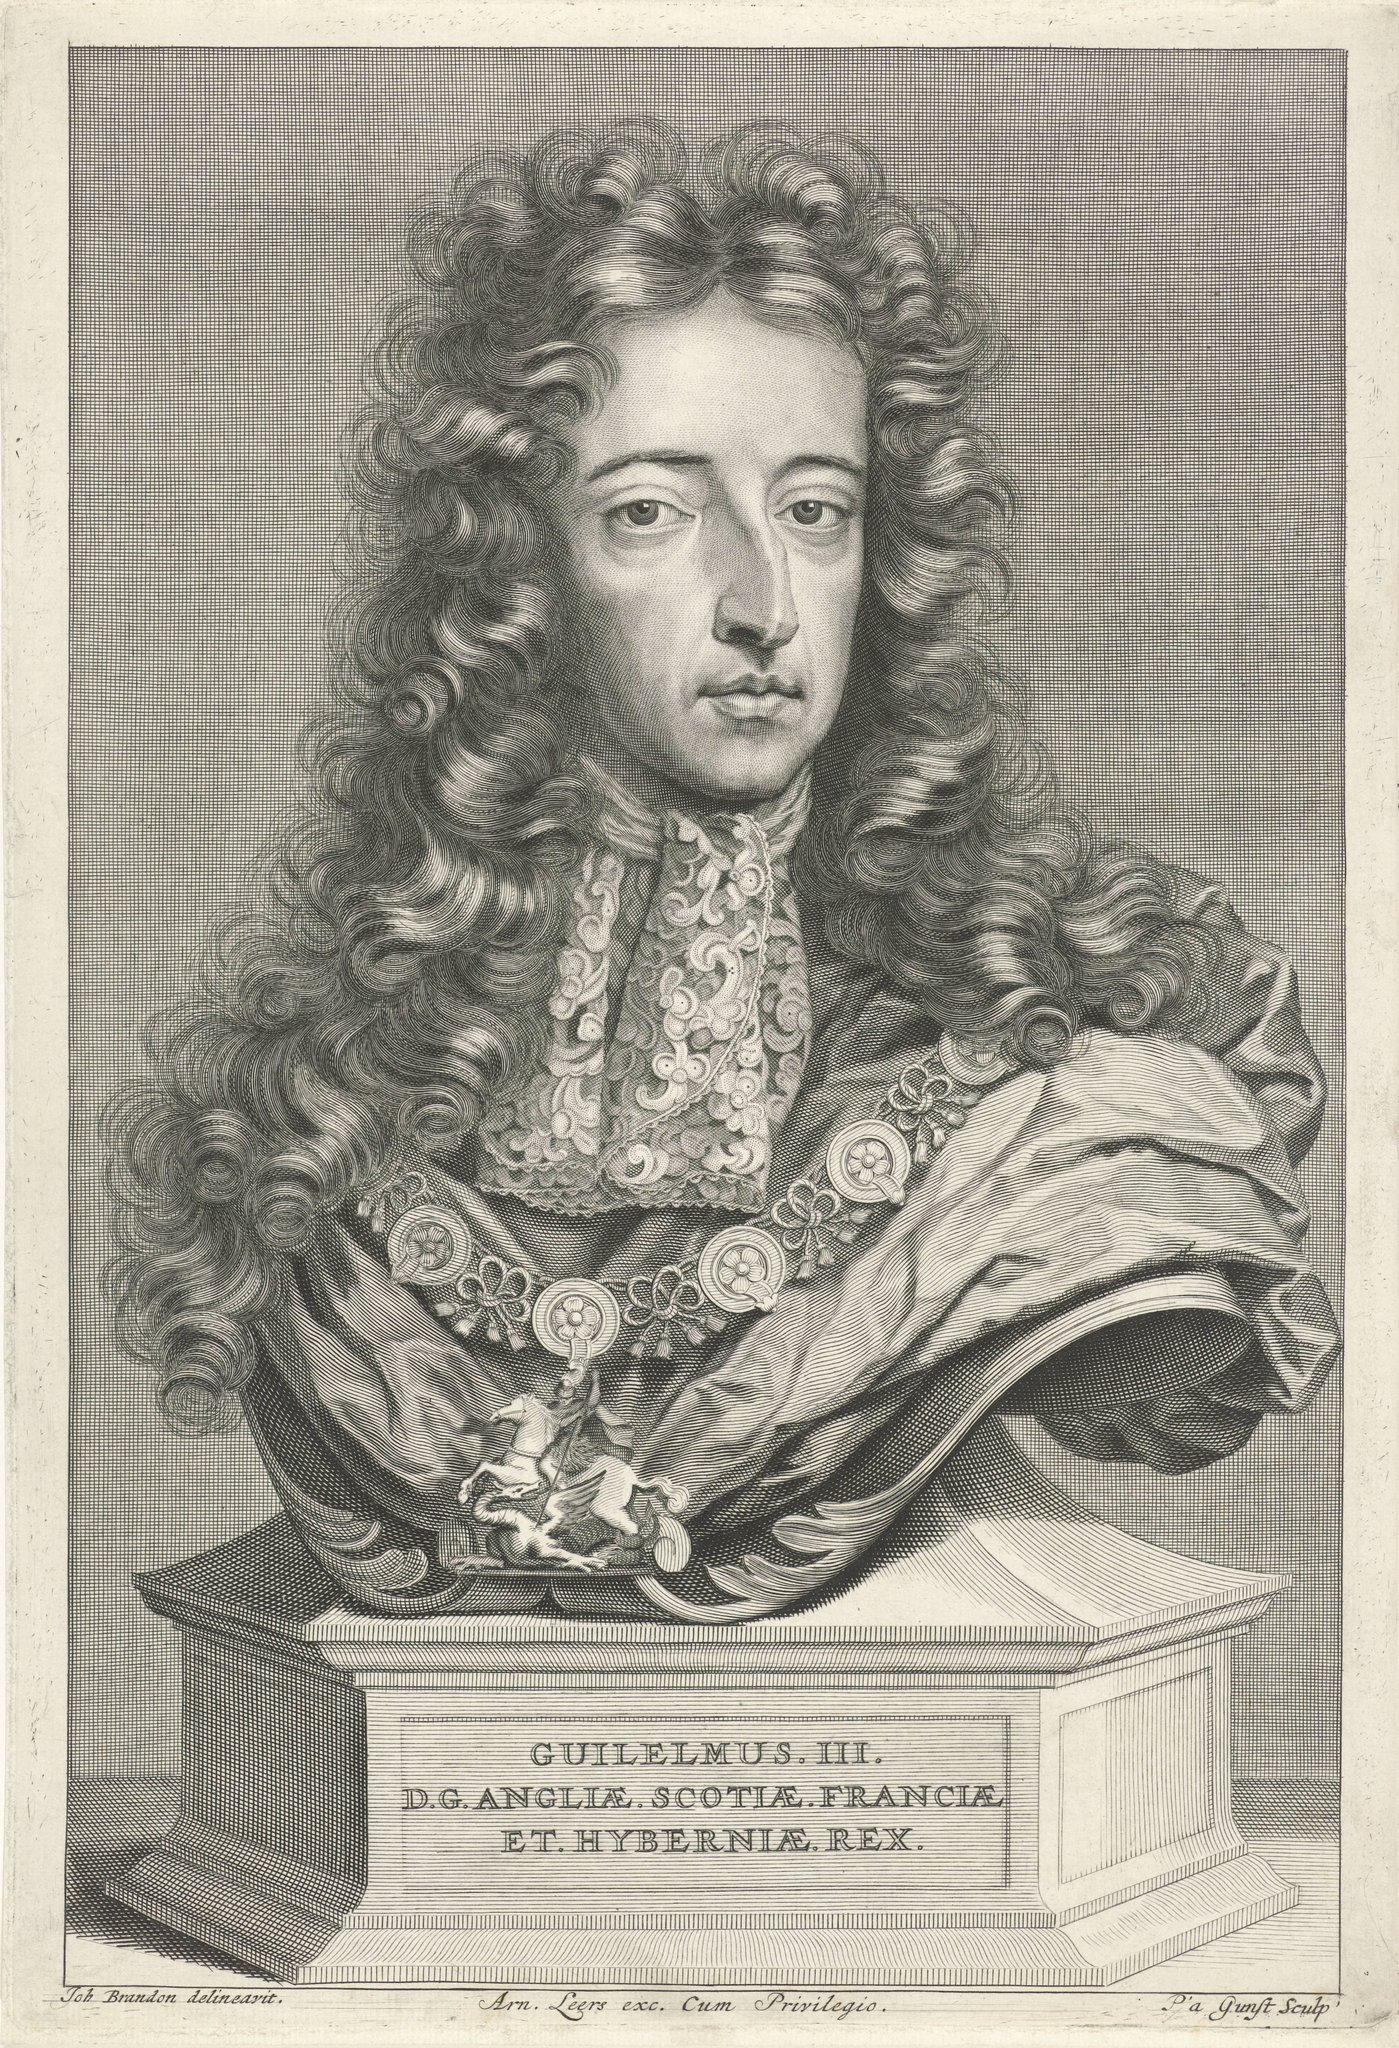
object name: print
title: Portret van Willem III, prins van Oranje-Nassau, koning van Engeland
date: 1689-1731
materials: paper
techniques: engraving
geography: amsterdam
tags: the hague, william iii (prince of orange and king of england, scotland, and ireland), knighthood order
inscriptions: collector's mark: Lugt 2760, collector's mark: Lugt 2228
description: Borstbeeld van Willem III, prins van Oranje-Nassau, koning van Engeland. Hij draagt het ordeteken van de Kousenband.